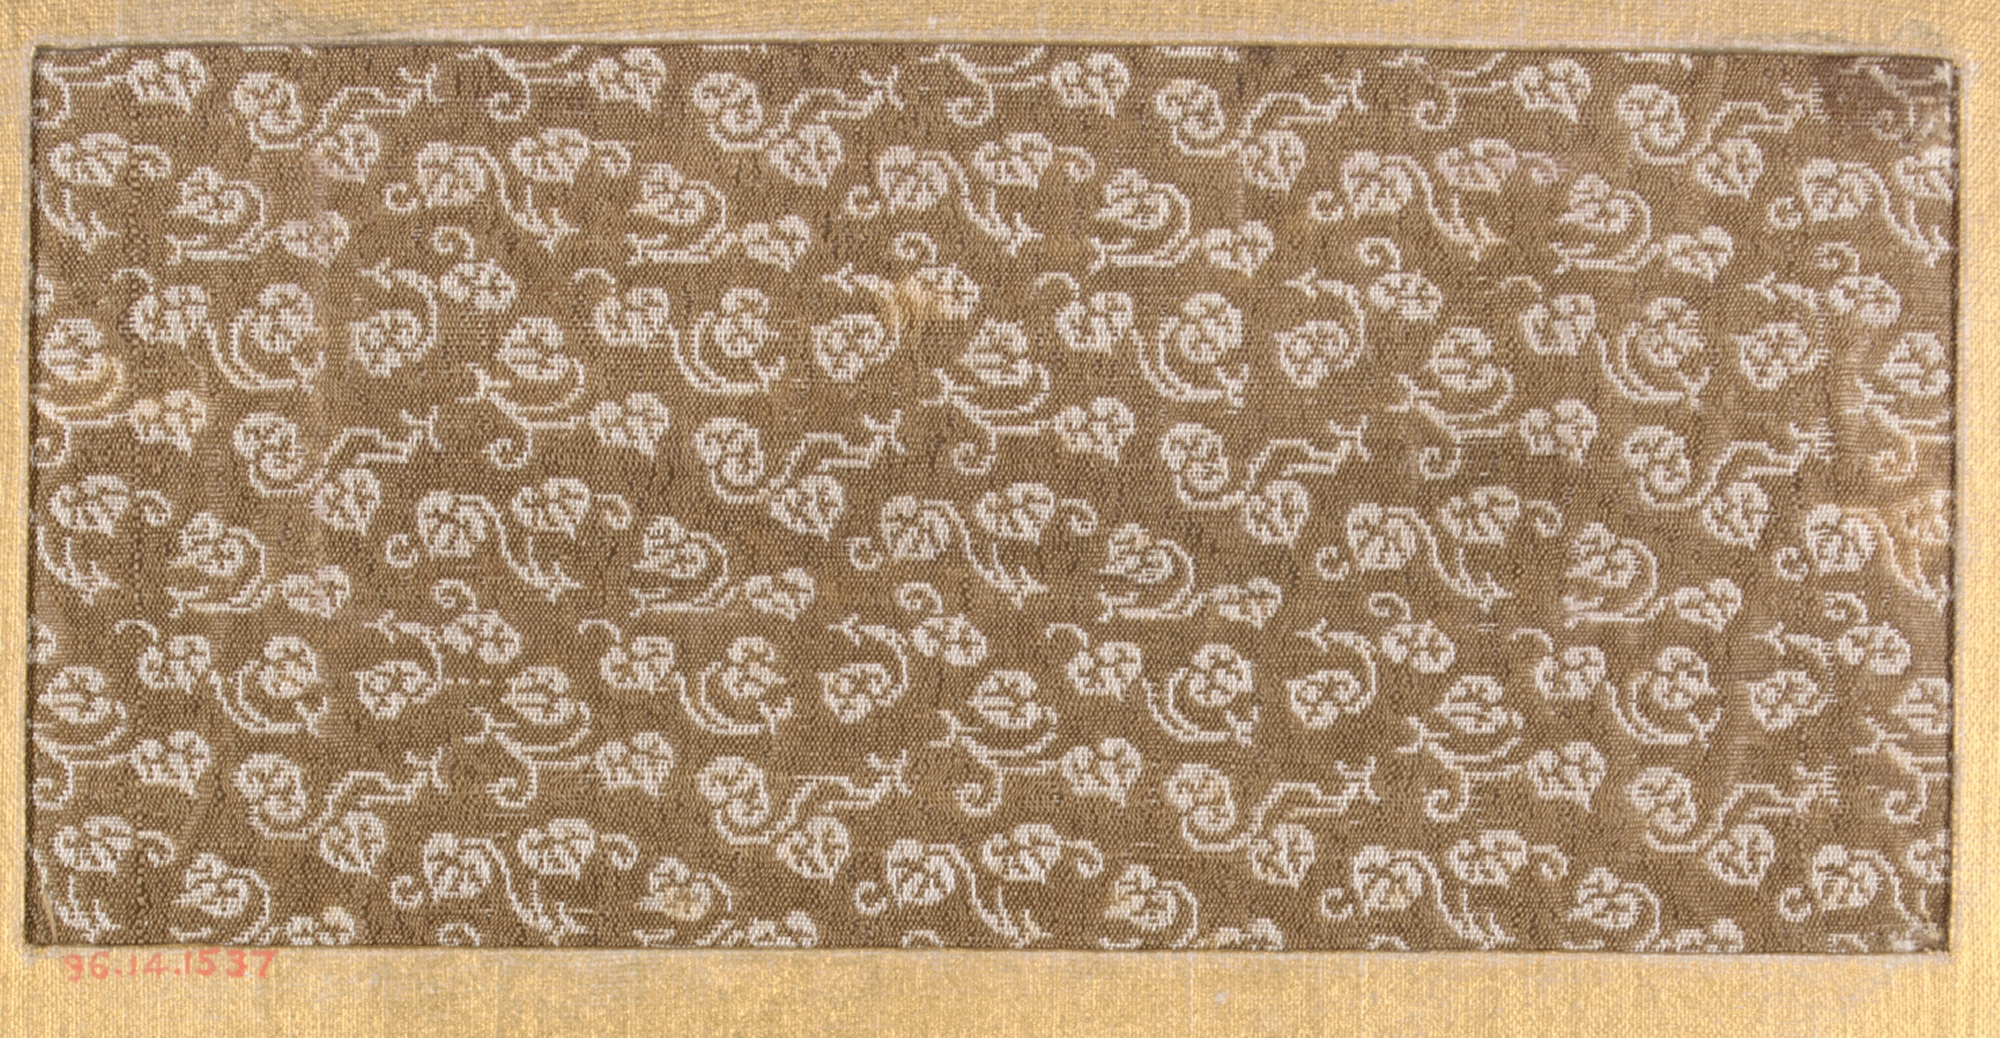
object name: piece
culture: japanese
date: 1701-1900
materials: silk